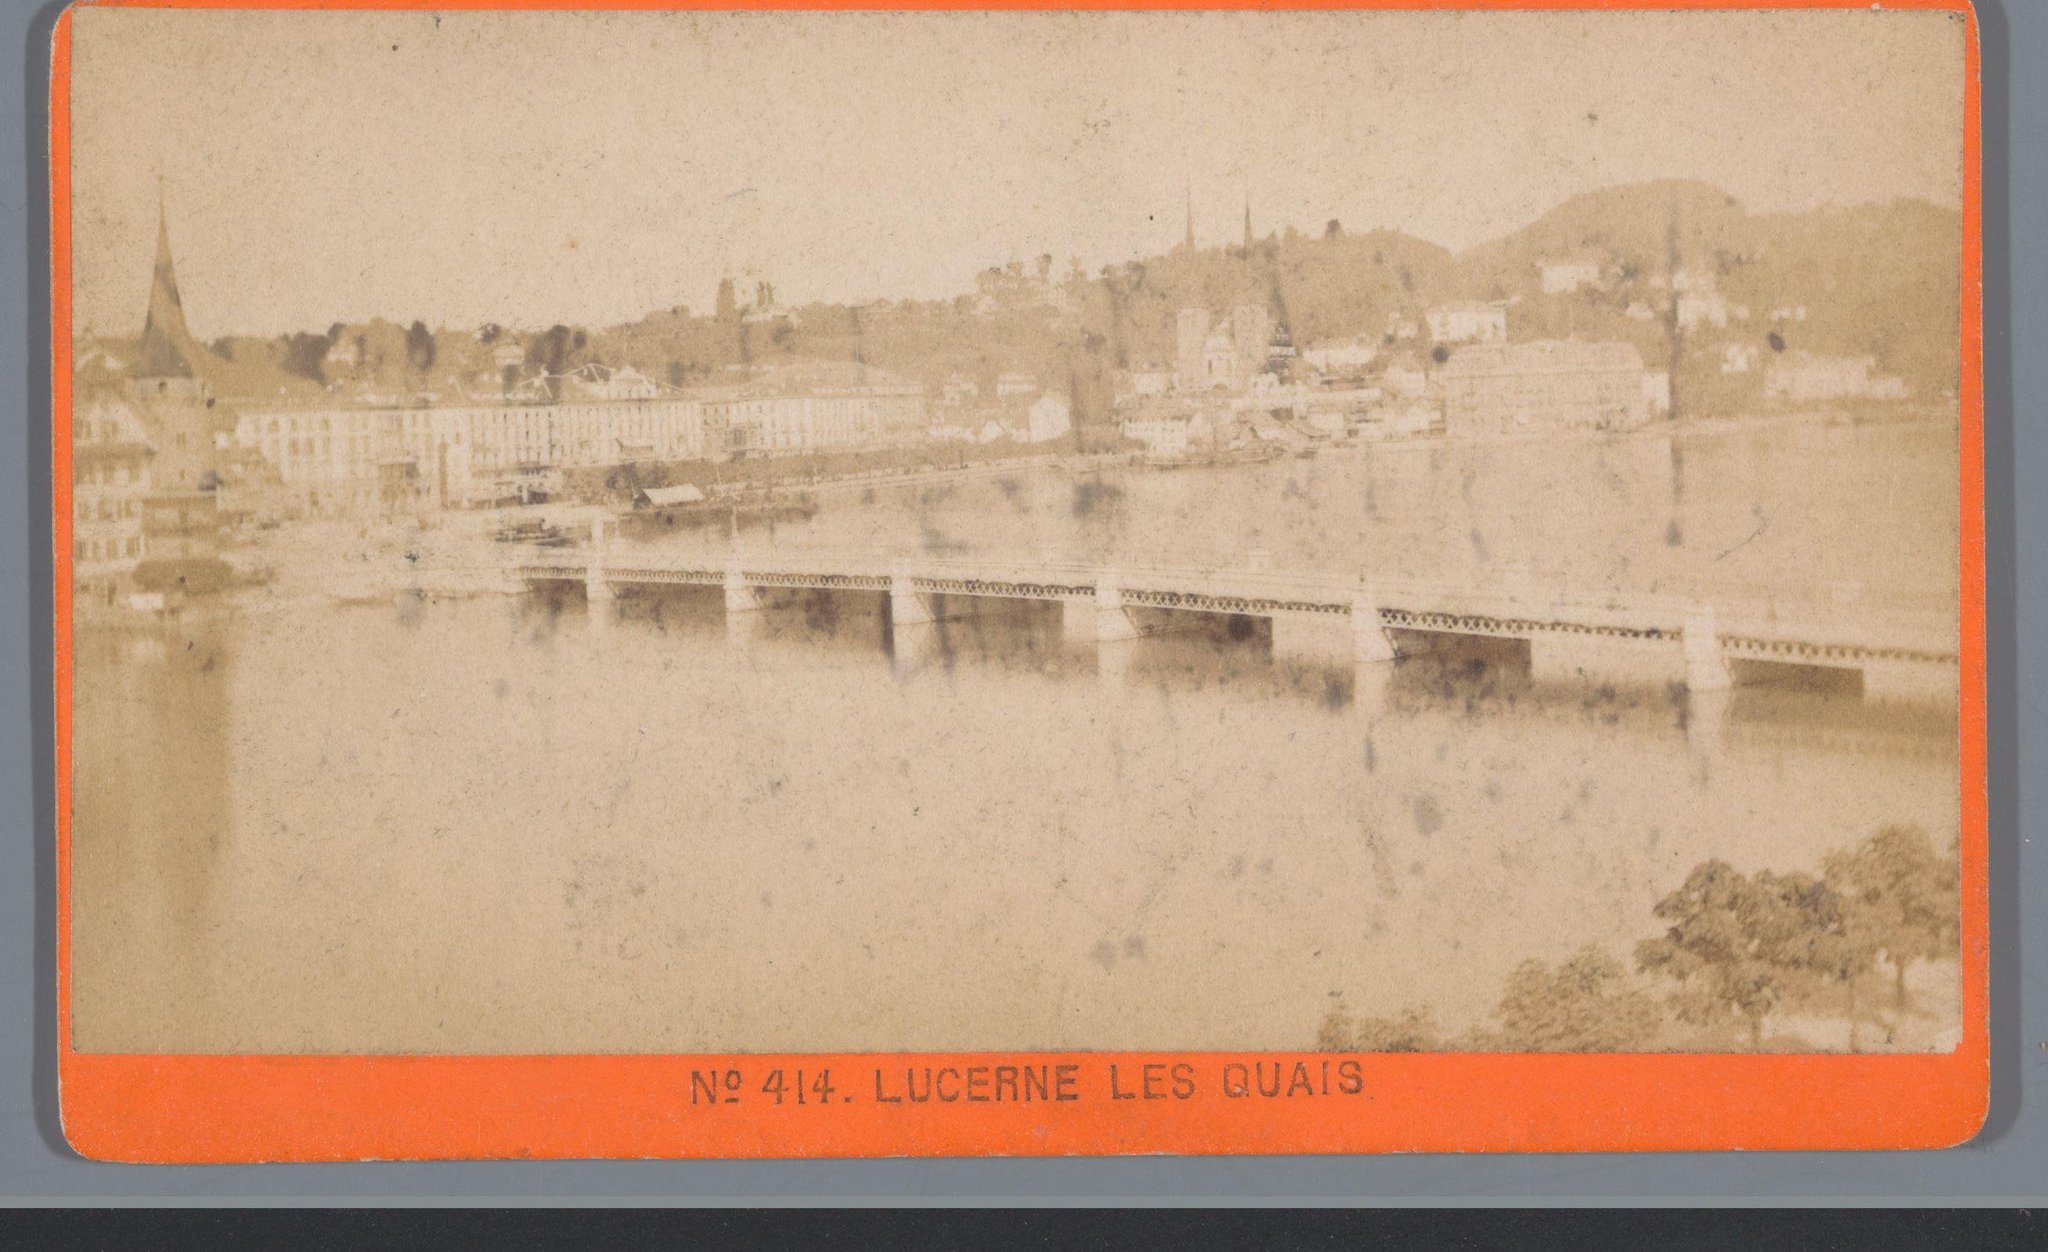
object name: carte de visite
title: Brug over de Reuss in Luzern, Zwitserland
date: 1870-1883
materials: cardboard, paper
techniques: albumen print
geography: lucerne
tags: bridge in city across river, canal, etc.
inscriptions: number: ‘No 414.’, inscription: ‘No....../ MAISON DES TROIS ROIS’